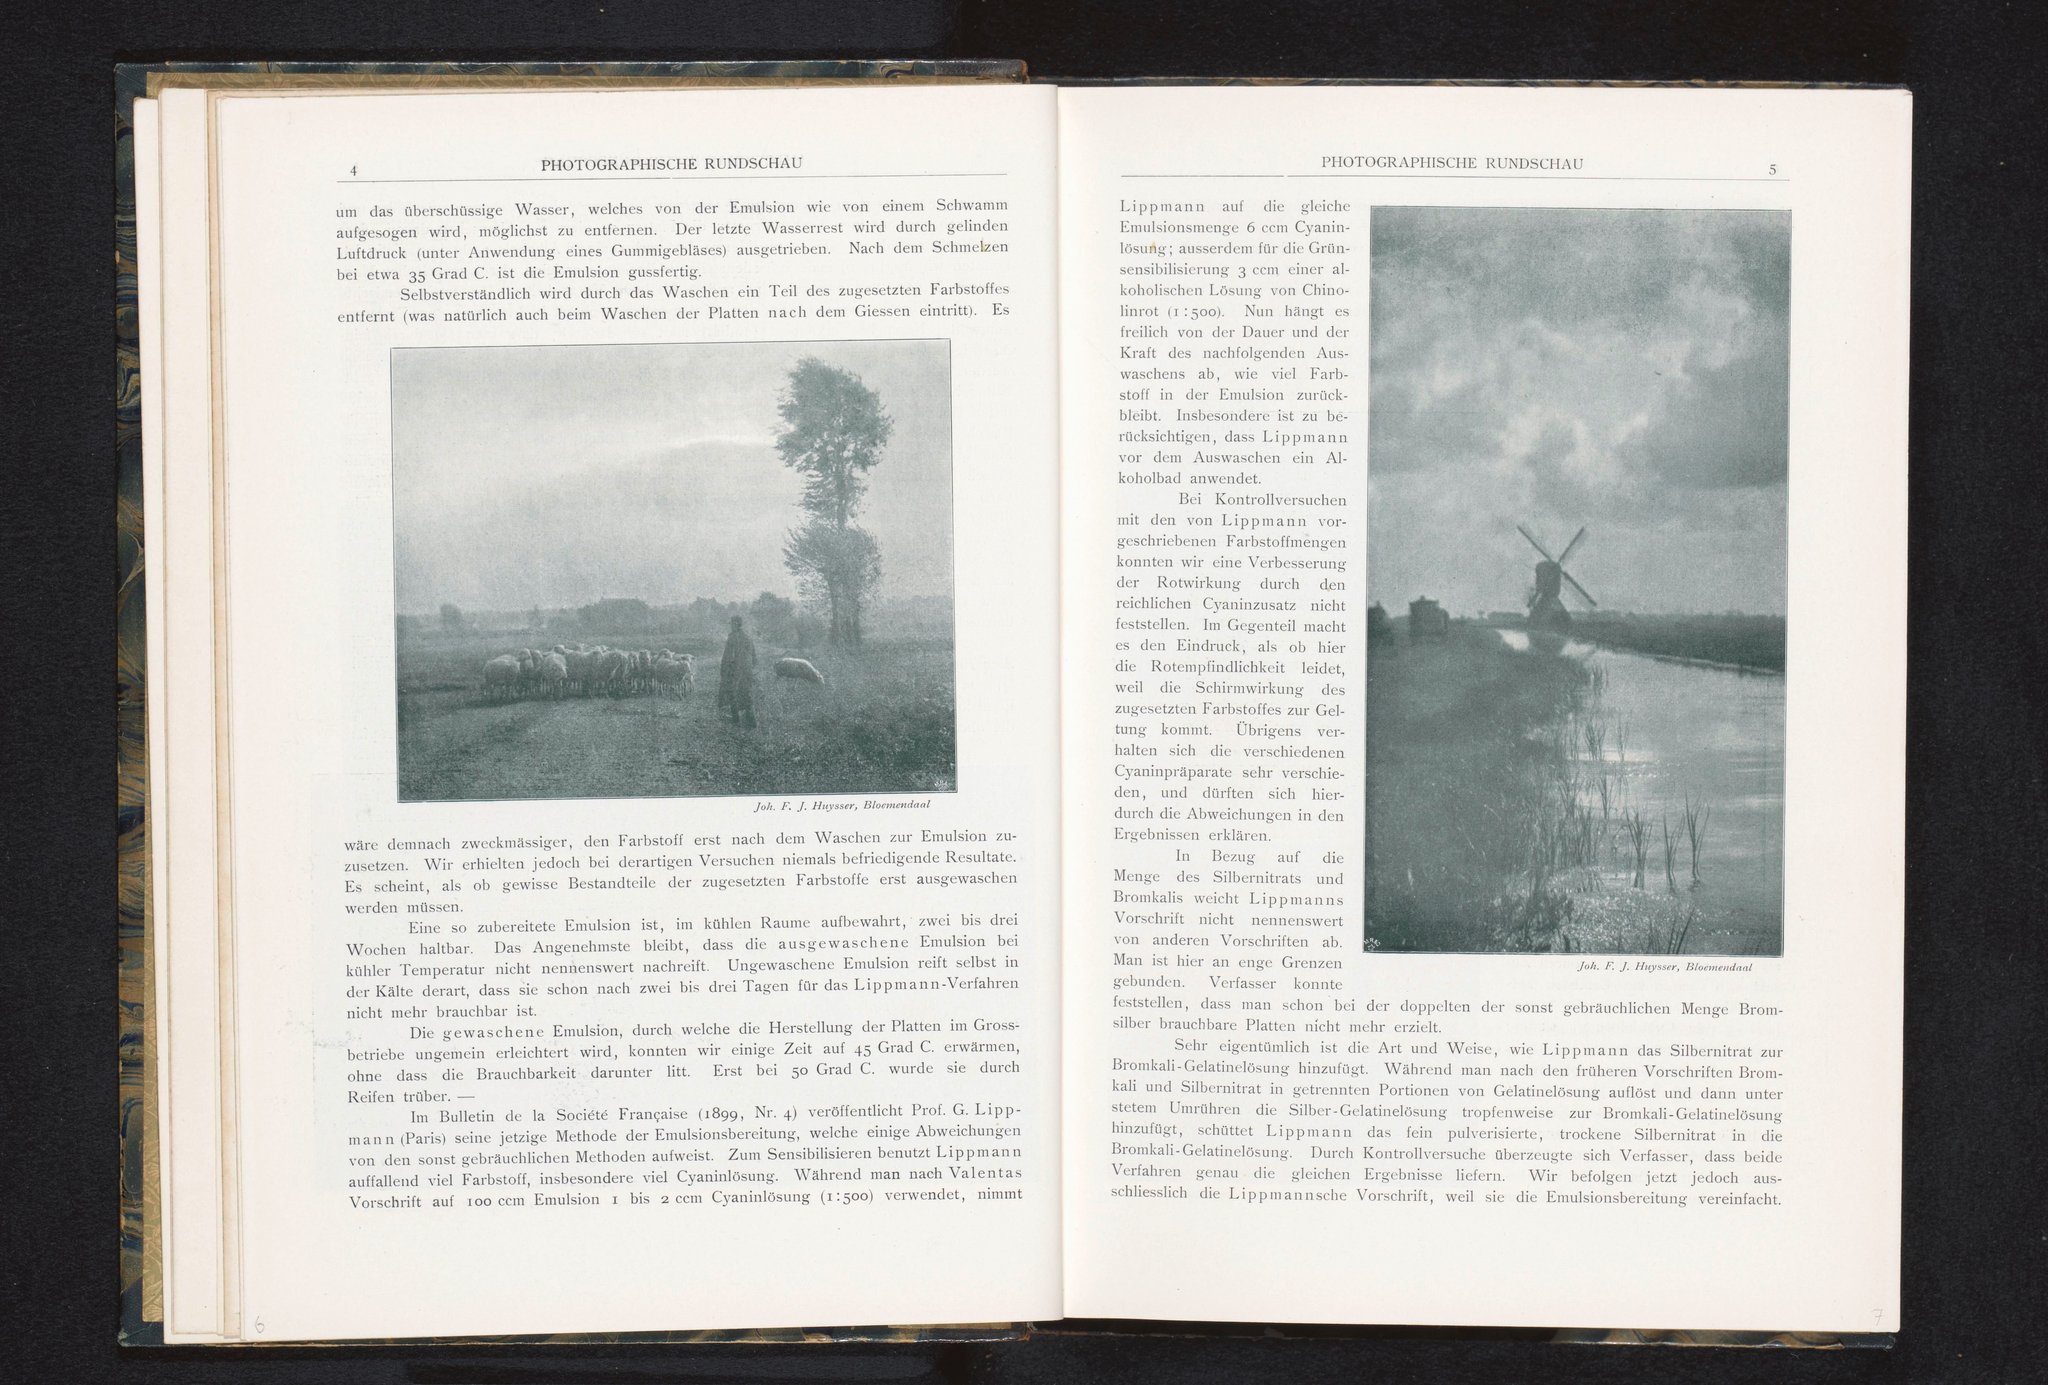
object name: page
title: Gezicht op een weiland met een sloot en een molen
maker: johan huijsser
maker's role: fotograaf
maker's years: 1868-1924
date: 1895-1900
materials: paper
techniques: autotype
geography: berlin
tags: meadow, pasture, windmill in landscape, small canal, ditch